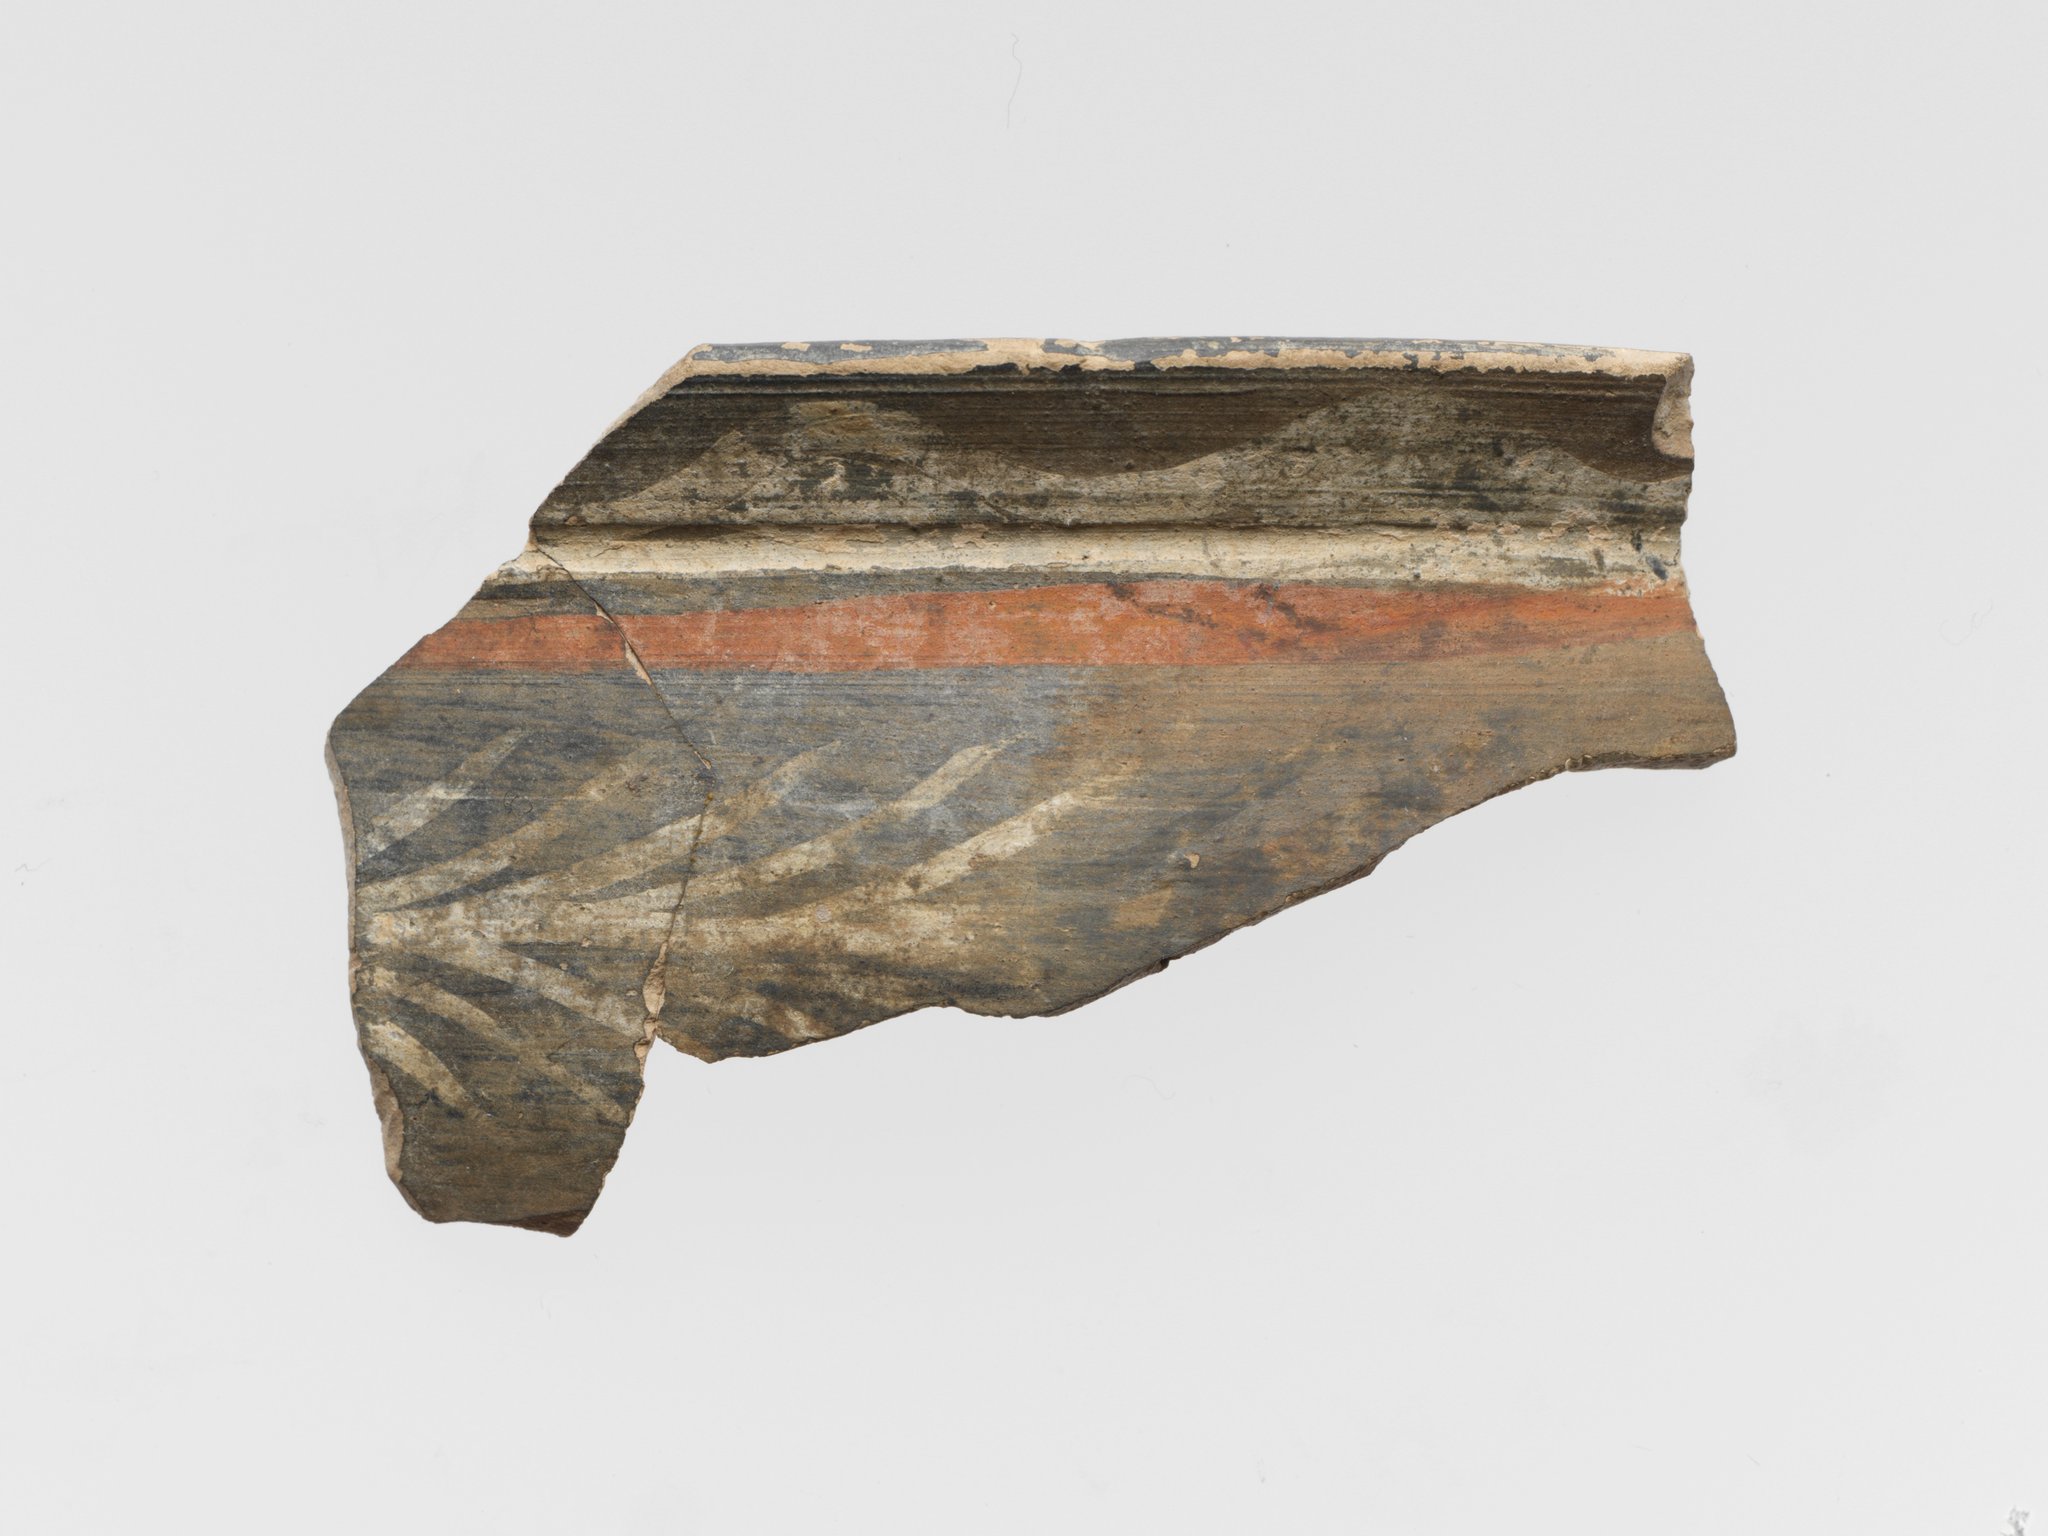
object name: vase fragment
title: Terracotta rim of a cup with fern pattern and bands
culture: minoan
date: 1800-1700 BCE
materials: terracotta